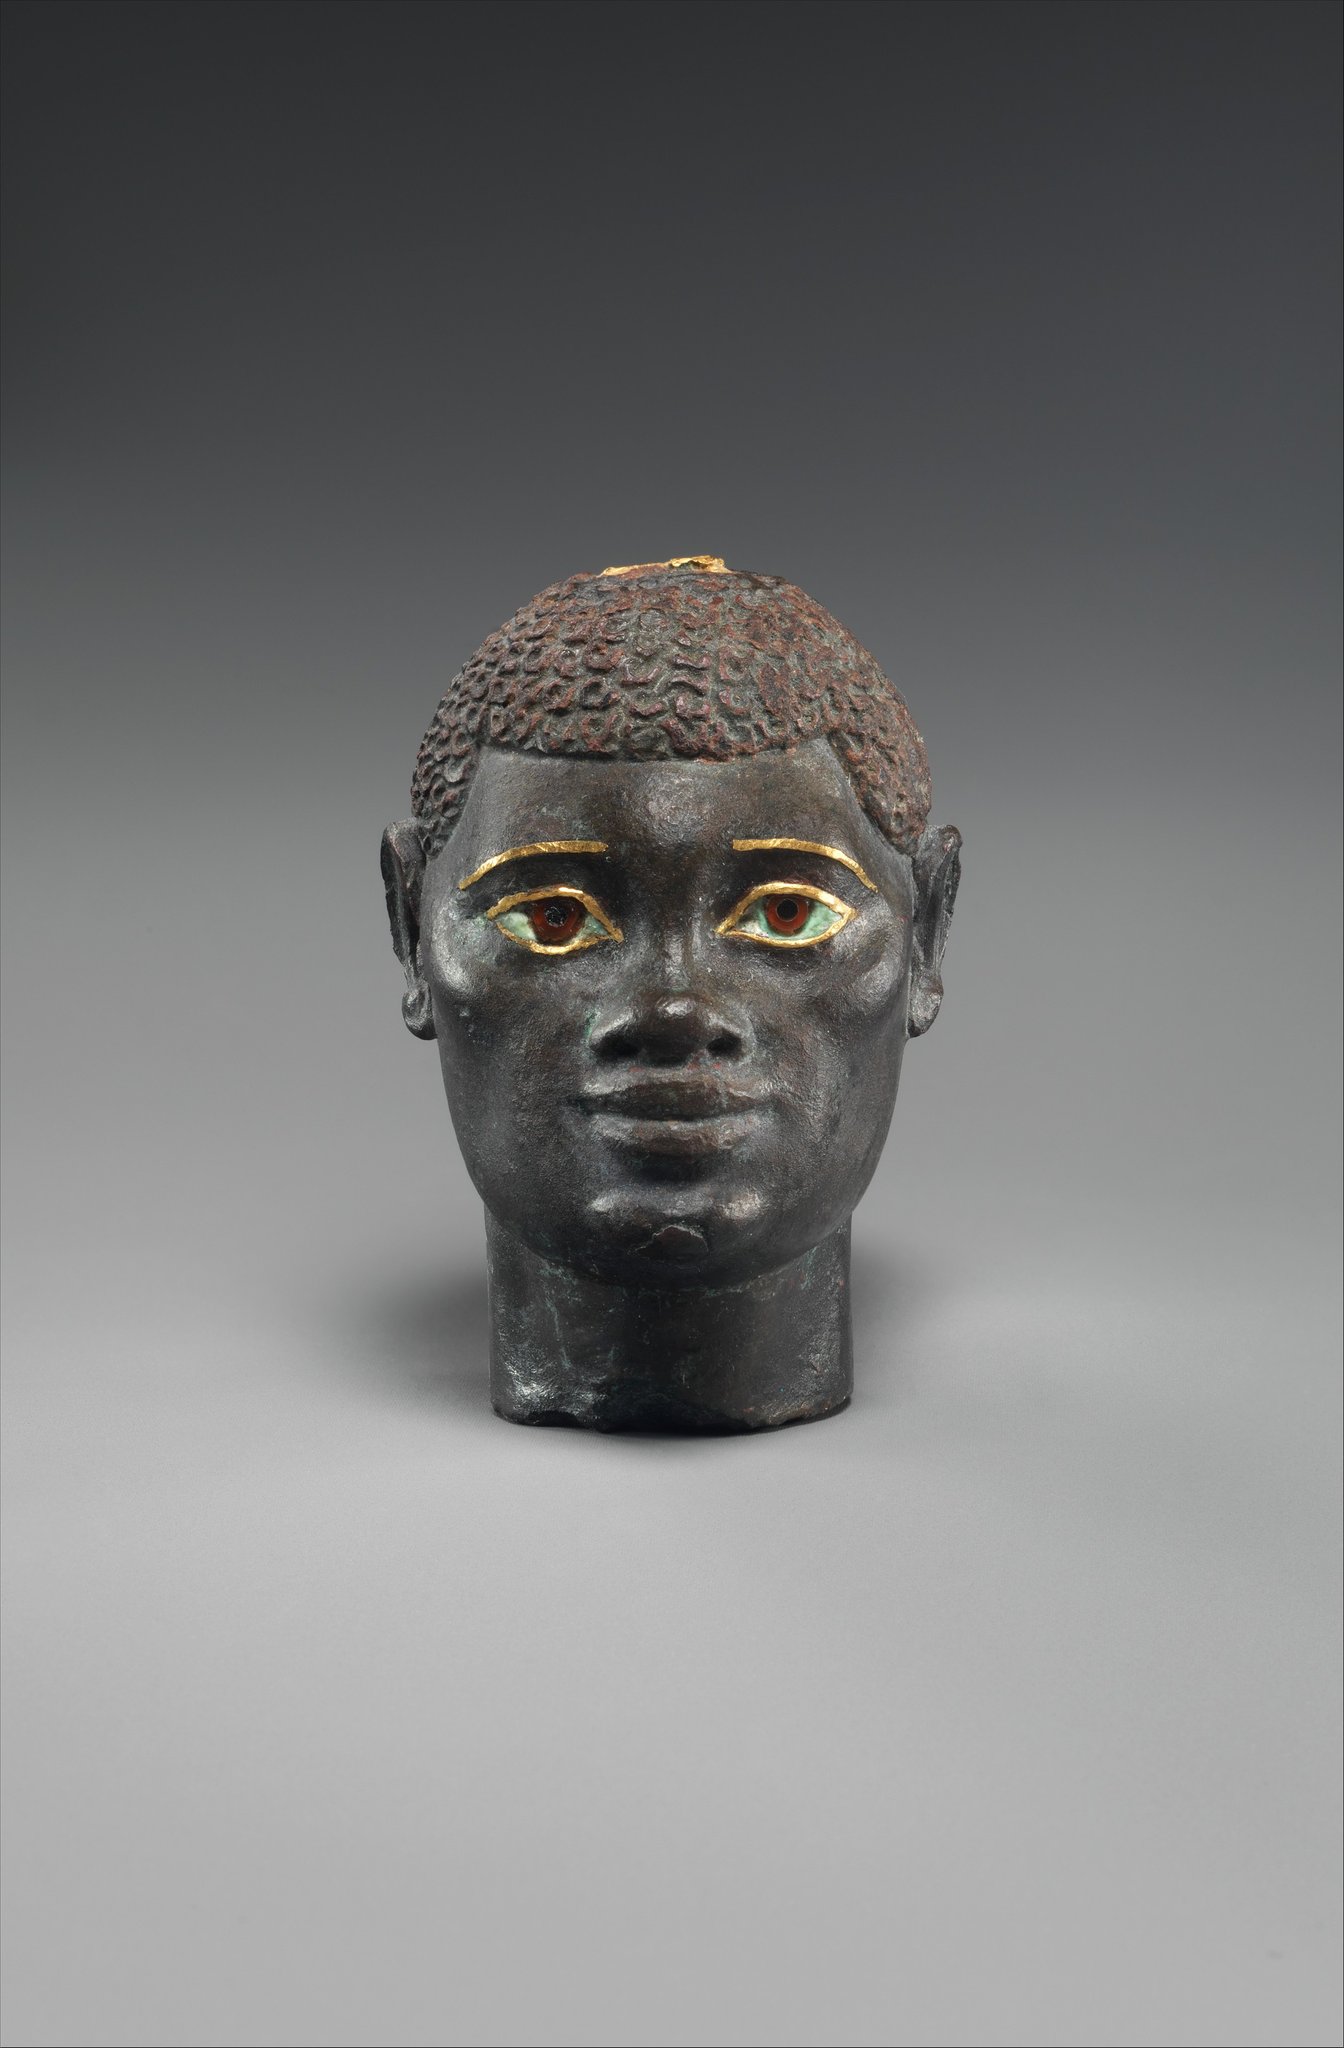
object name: head, ethiopian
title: Head of an "Ethiopian" depicted in Hellenistic mode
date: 332-330 BCE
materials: bronze, gemstone, gold, obsidian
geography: delta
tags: heads,men